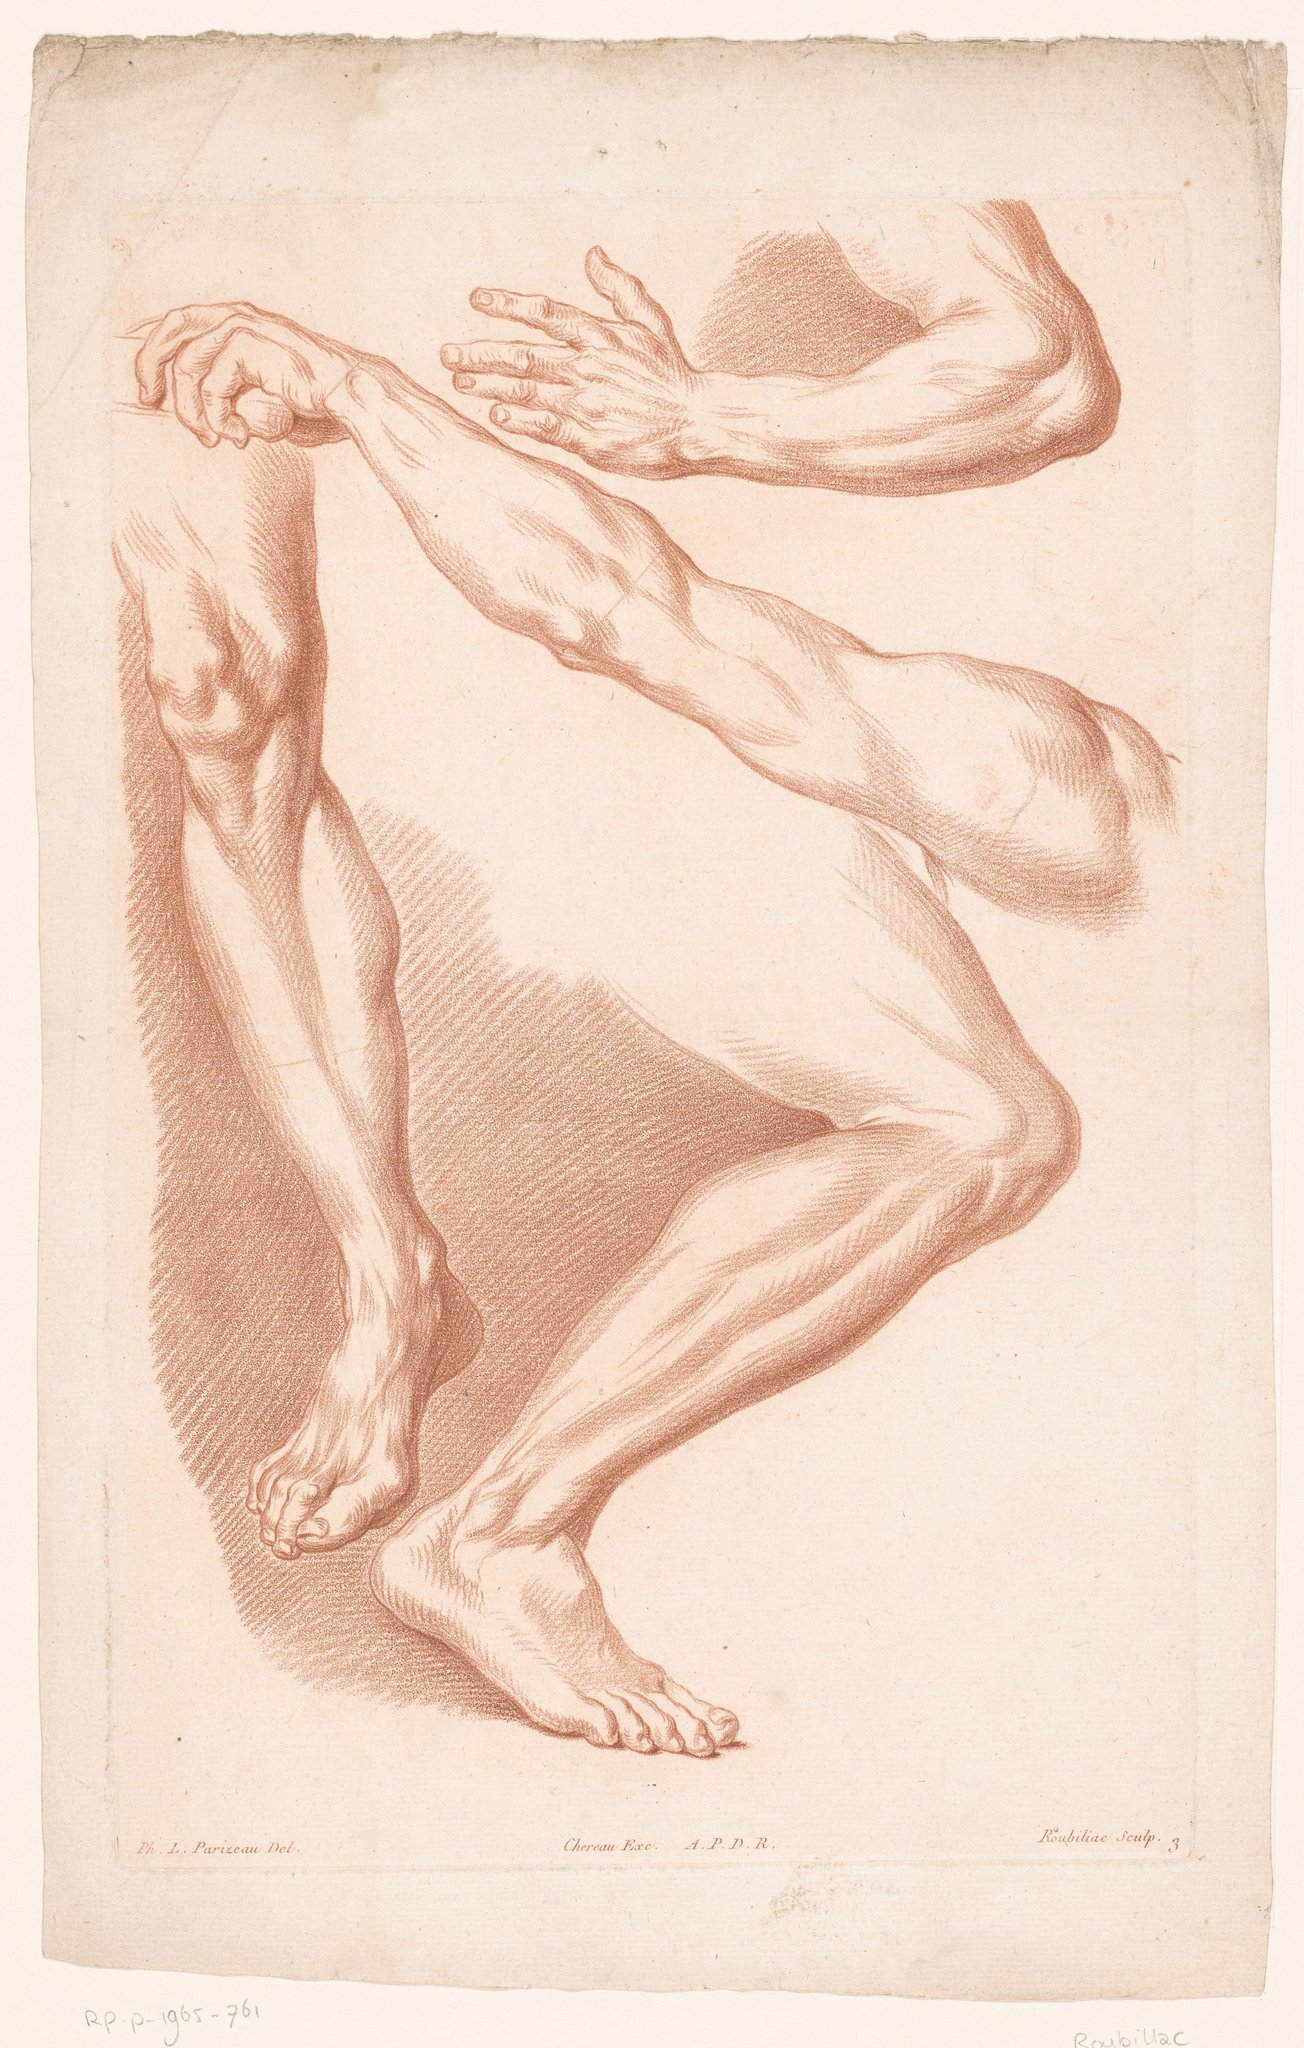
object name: print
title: Verschillende aanzichten van twee benen en twee armen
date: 1780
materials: paper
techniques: printmaking, etching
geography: france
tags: drawing, sketch, arms, legs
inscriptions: collector's mark: Lugt 2228